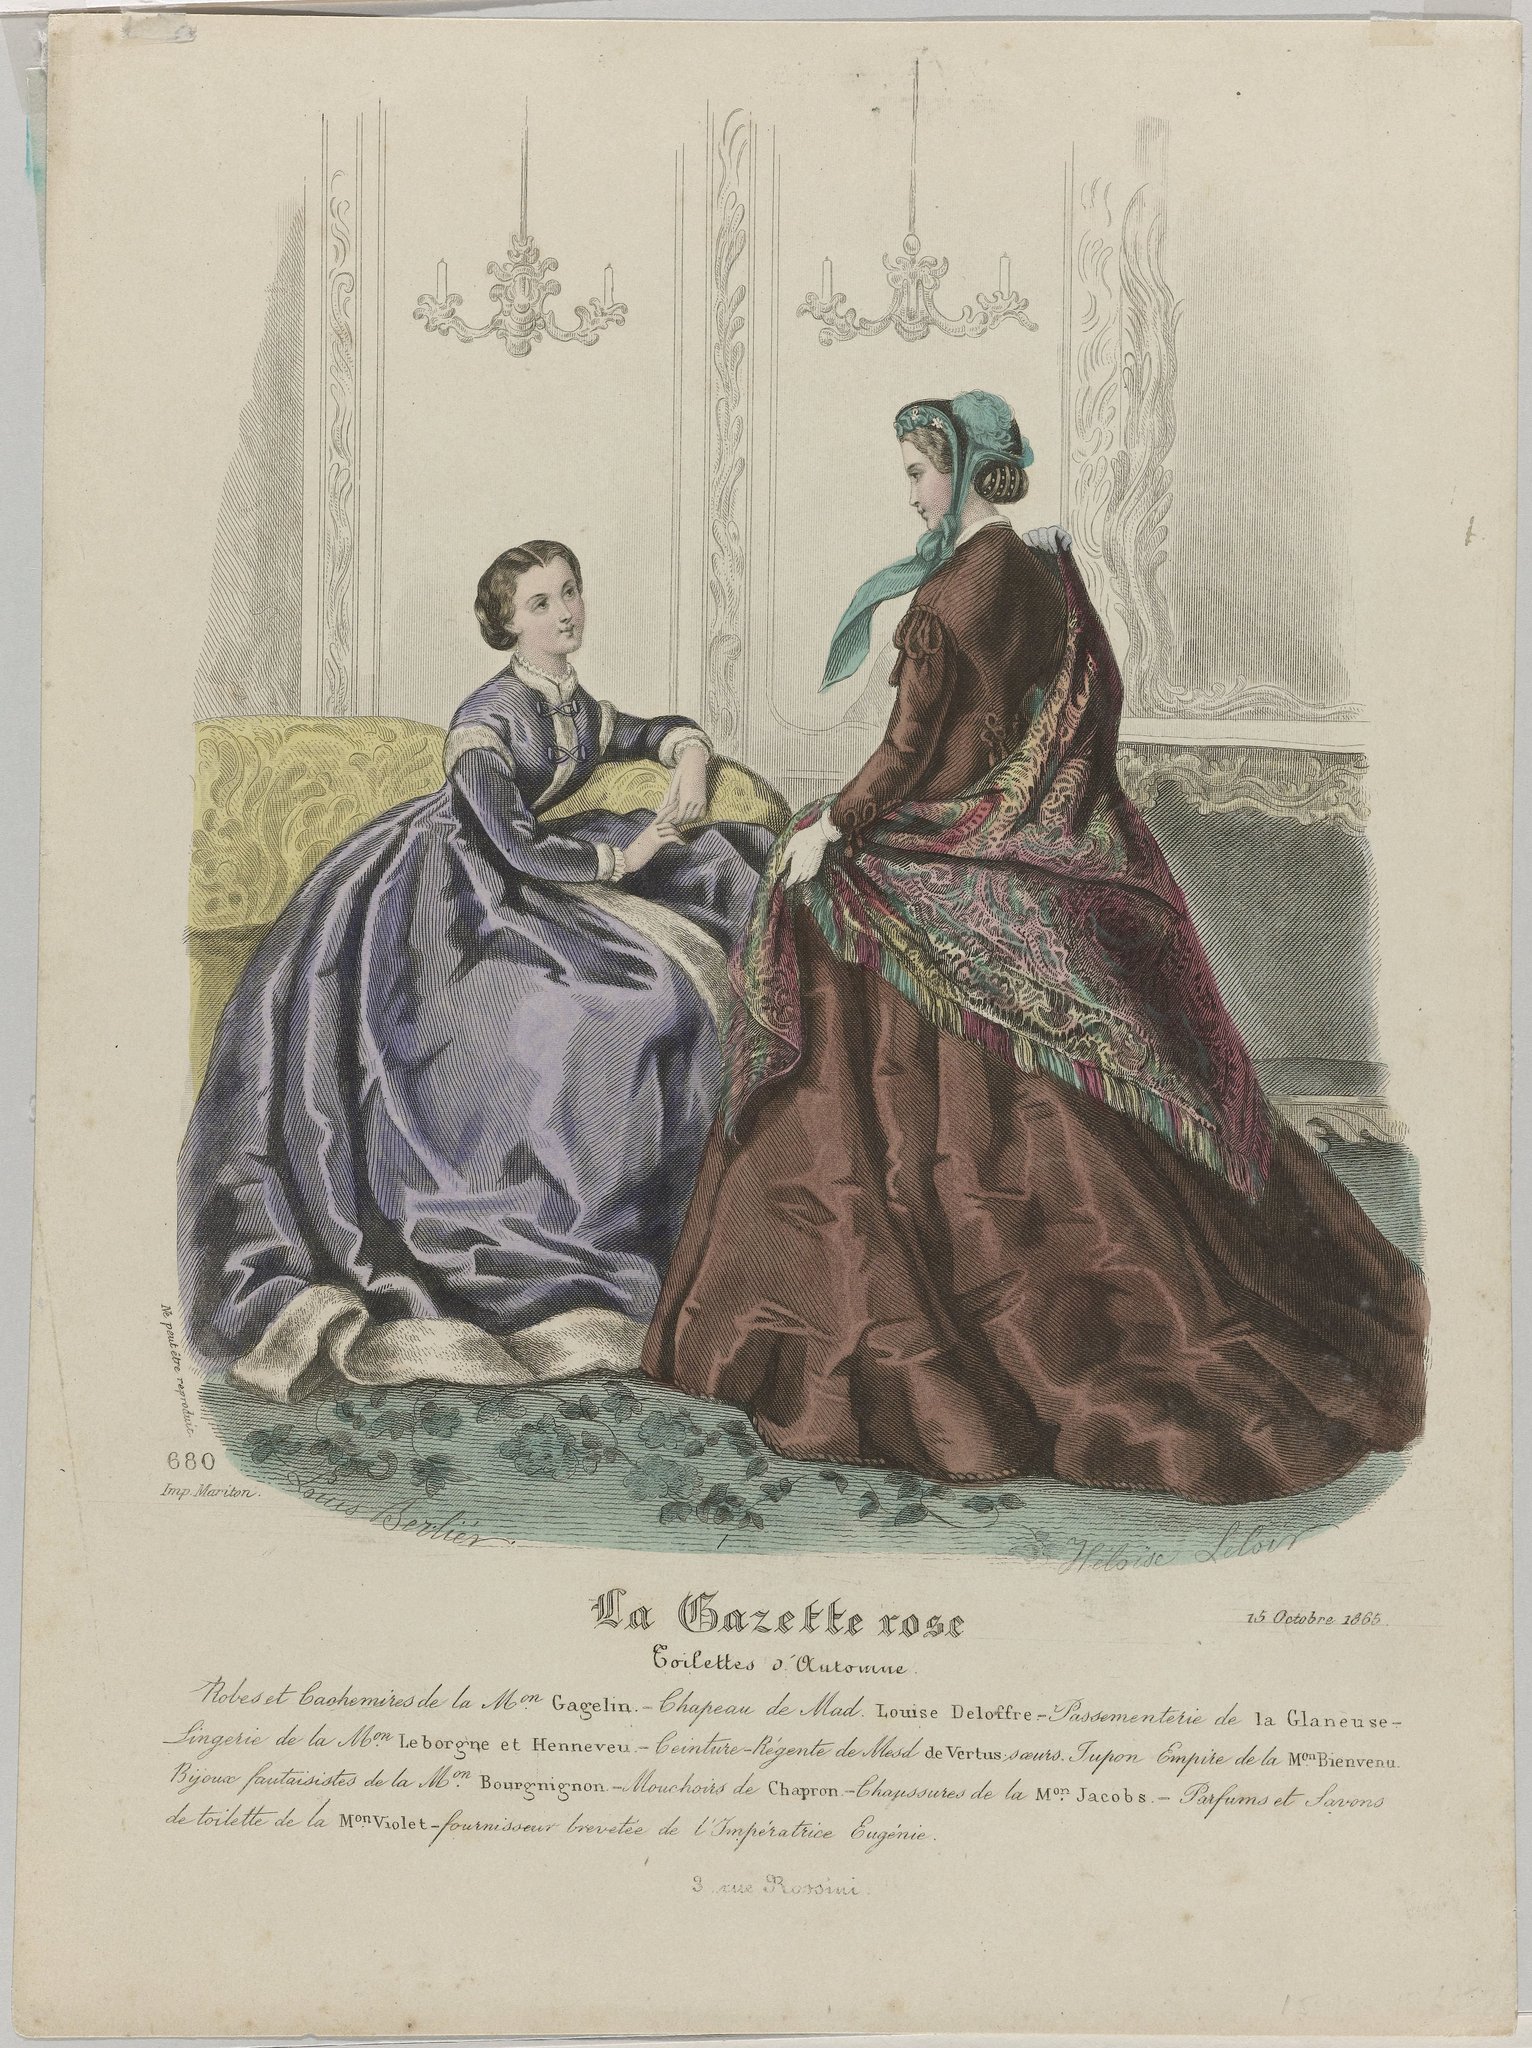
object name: fashion print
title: La Gazette Rose, 15 Octobre 1865, No. 680 : Robes et Cachmires (...)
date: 1865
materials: paper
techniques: engraving, hand coloring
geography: paris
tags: clothing for the upper part of the body (shawl) (+ women's clothes), ornamental parts of clothing (+ women's clothes), fashion plates, head-gear: hat (+ women's clothes), gloves, mittens, etc. (+ women's clothes)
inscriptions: title: ‘La Gazette rose / Toilettes d'Automne’, address: ‘3 rue Rossini’, caption: ‘Robes et Cachemires de la M.on Gagelin. - Chapeau de Mad. Louise Deloffre.- Passementerie de la Glaneuse - Lingerie de la M.on Le borgne et Henneveu. _ Ceinture - Régente de Mesd de Vertus doeurs. Jupon Empire de la M.on Bienvenu. Bijoux fautaisistes de la M.on Bourgnignon.- Mouchoirs de Chapron.- Chaussures de la M.on Jacobs. - Parfums et savons de toilette de la M.on Violet - fournisseur brevetée de l'Impératrice Eugénie.’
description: Twee vrouwen, van wie één op de rug gezien, in een interieur. Volgens het onderschrift: japonnen en kasjmiers (sjaal) van Gagelin. Hoed van Louise Deloffre. Hieronder enkele regels reclametekst voor verschillende producten. Prent uit het modetijschrift La Gazette Rose (1857-1884).